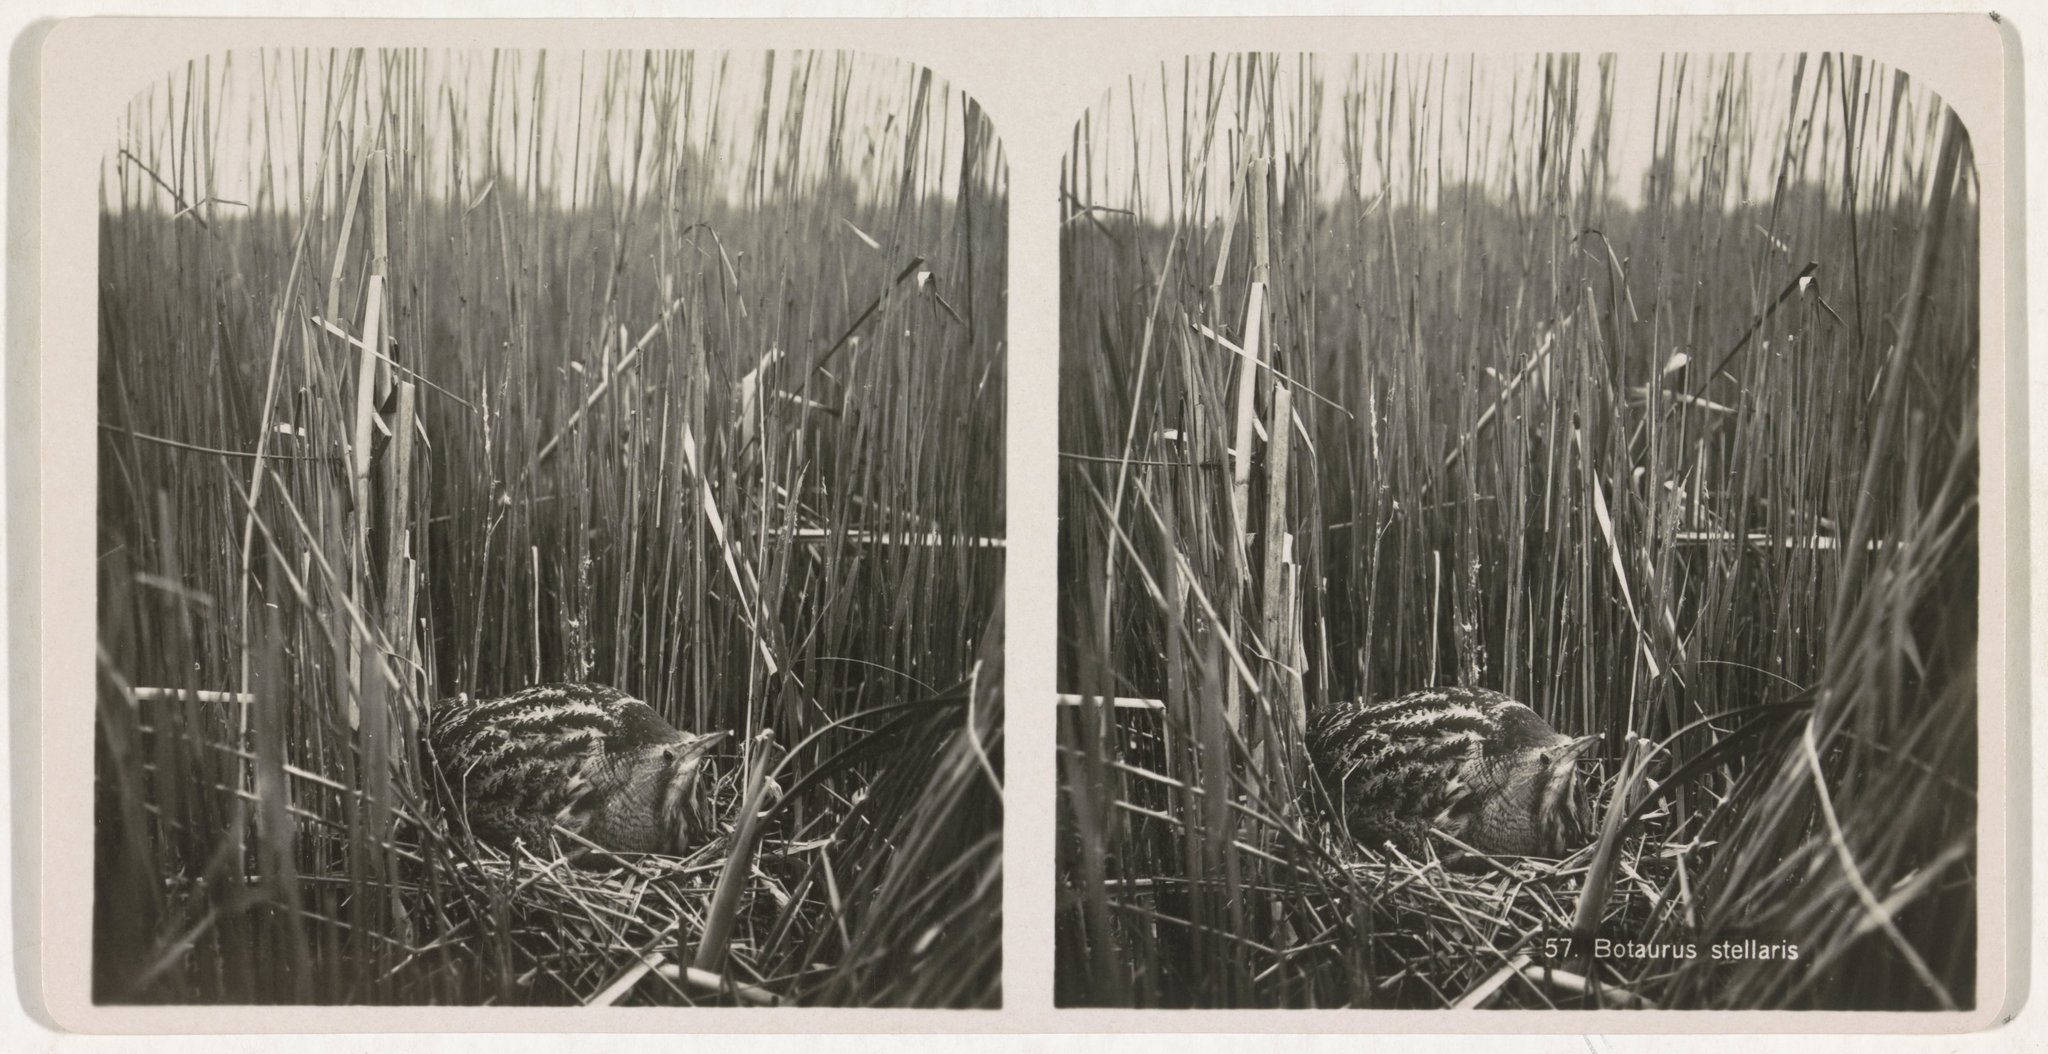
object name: stereograph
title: Roerdomp op nest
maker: adolphe burdet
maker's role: fotograaf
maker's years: 1860-1940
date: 1870-1940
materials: photographic support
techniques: gelatin silver print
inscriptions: label: ‘Roerdomp’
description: De foto is afkomstig uit een serie van 12 stereofoto's met moerasvogels die bewaard worden in het originele mapje. Bij dit mapje zit ook een blaadje met gedrukte tekst over de vogels.